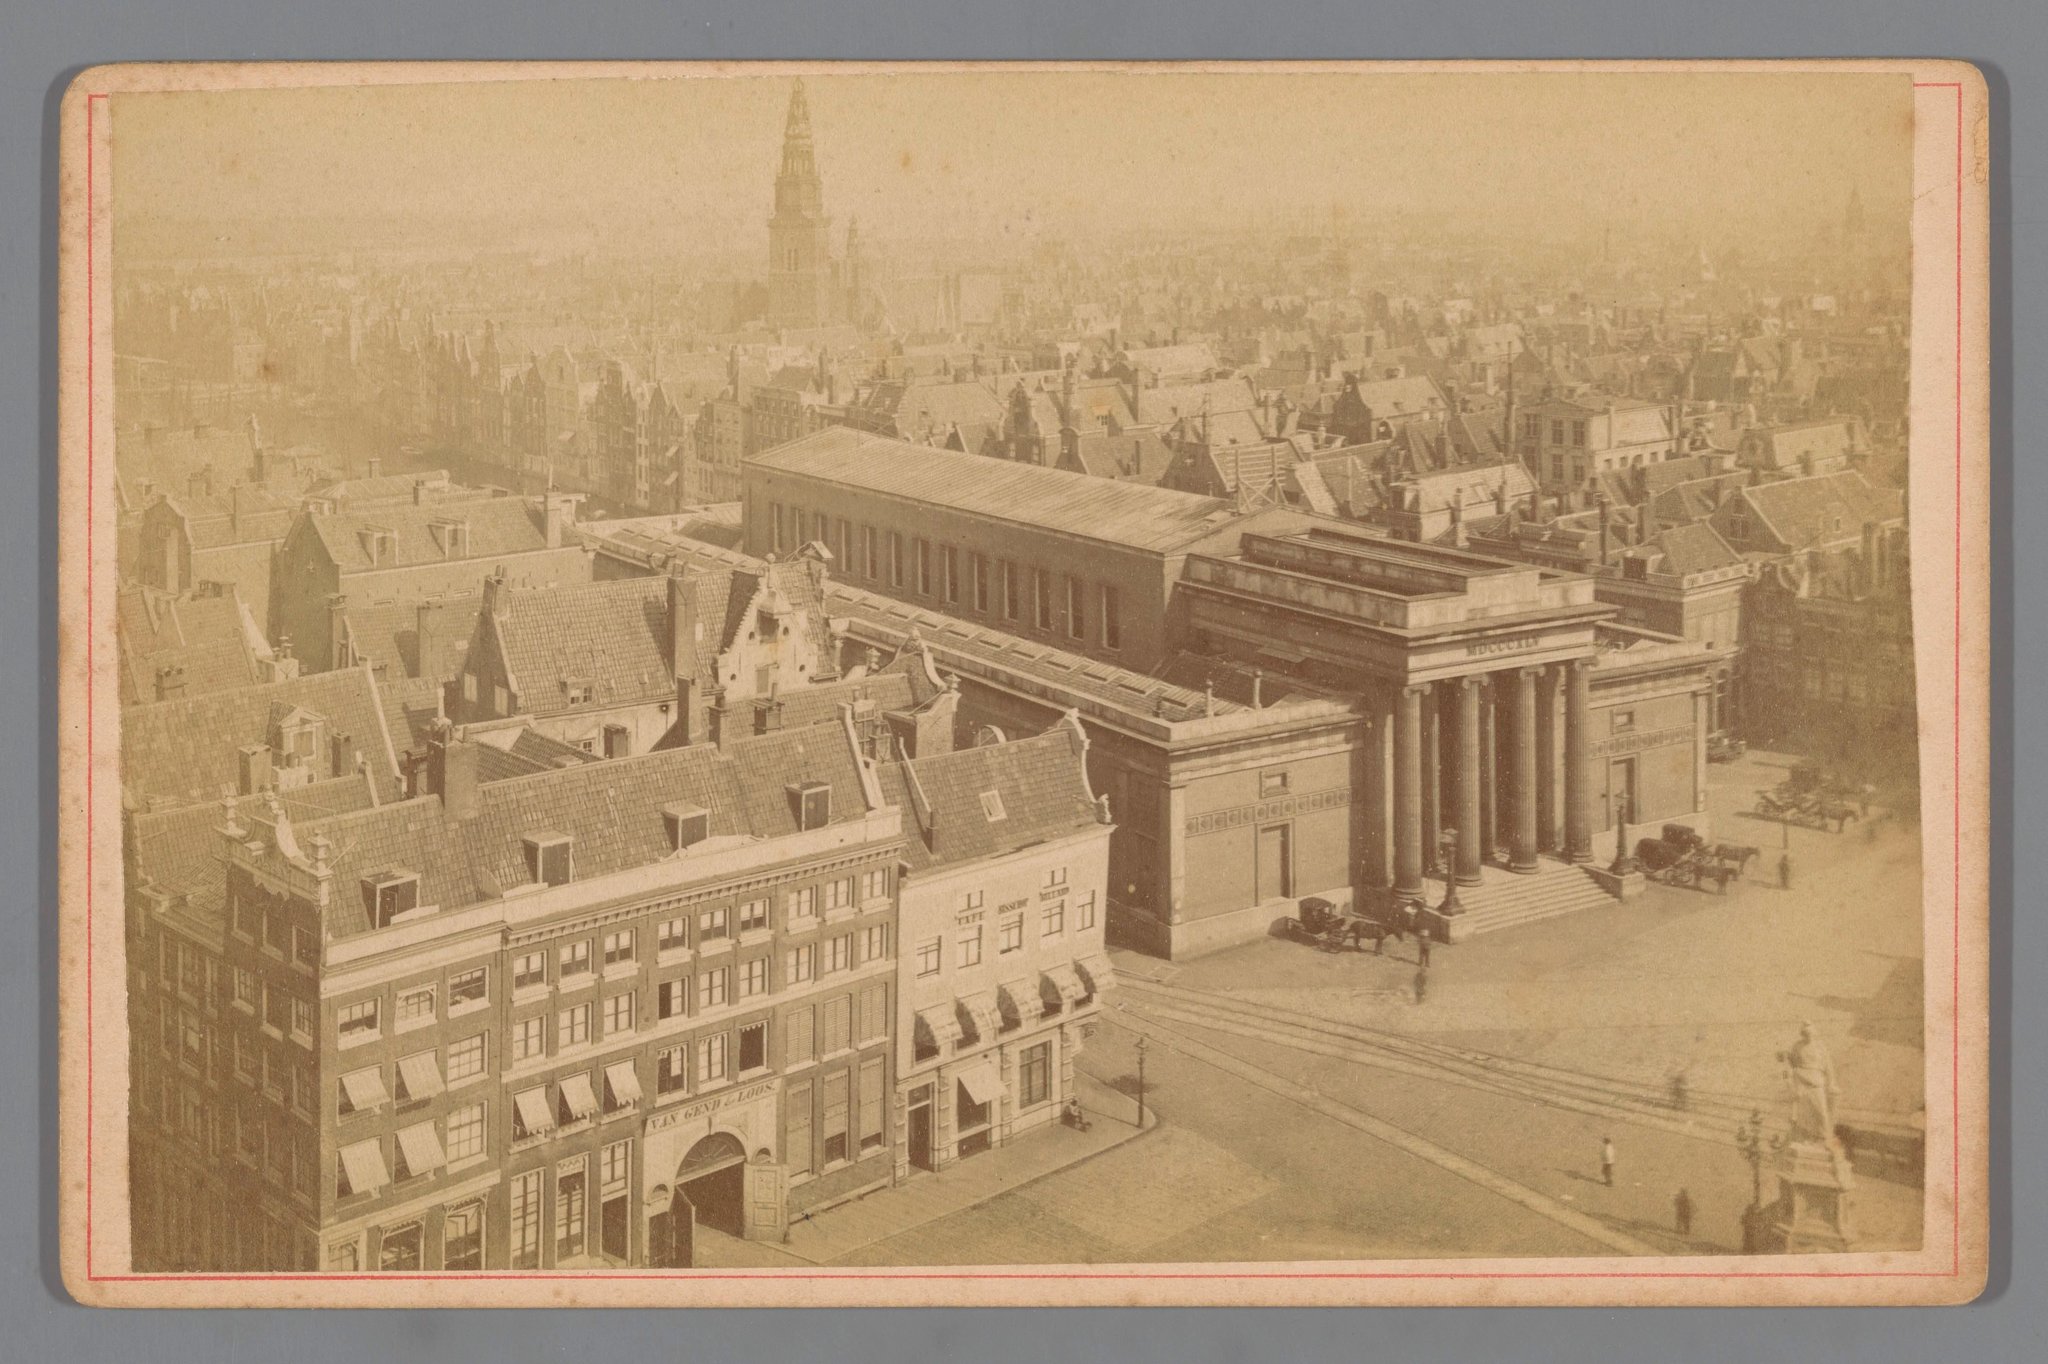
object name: cabinet photograph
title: Gezicht op de Beurs van Zocher op de Dam in Amsterdam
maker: Anonymous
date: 1850-1900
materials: cardboard, photographic support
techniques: albumen print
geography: amsterdam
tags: square, place, circus, etc., stock exchange, stock-market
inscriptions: annotation: ‘De voormalige kantoren en gebouwen der/ firma Van Gend & Loos op den Dam/ afgebroken in April 1886. -/ Cafe de Bisschop, hoek Dam-Damrak afgebroken/ en nieuw gebouwd in 1900.-’